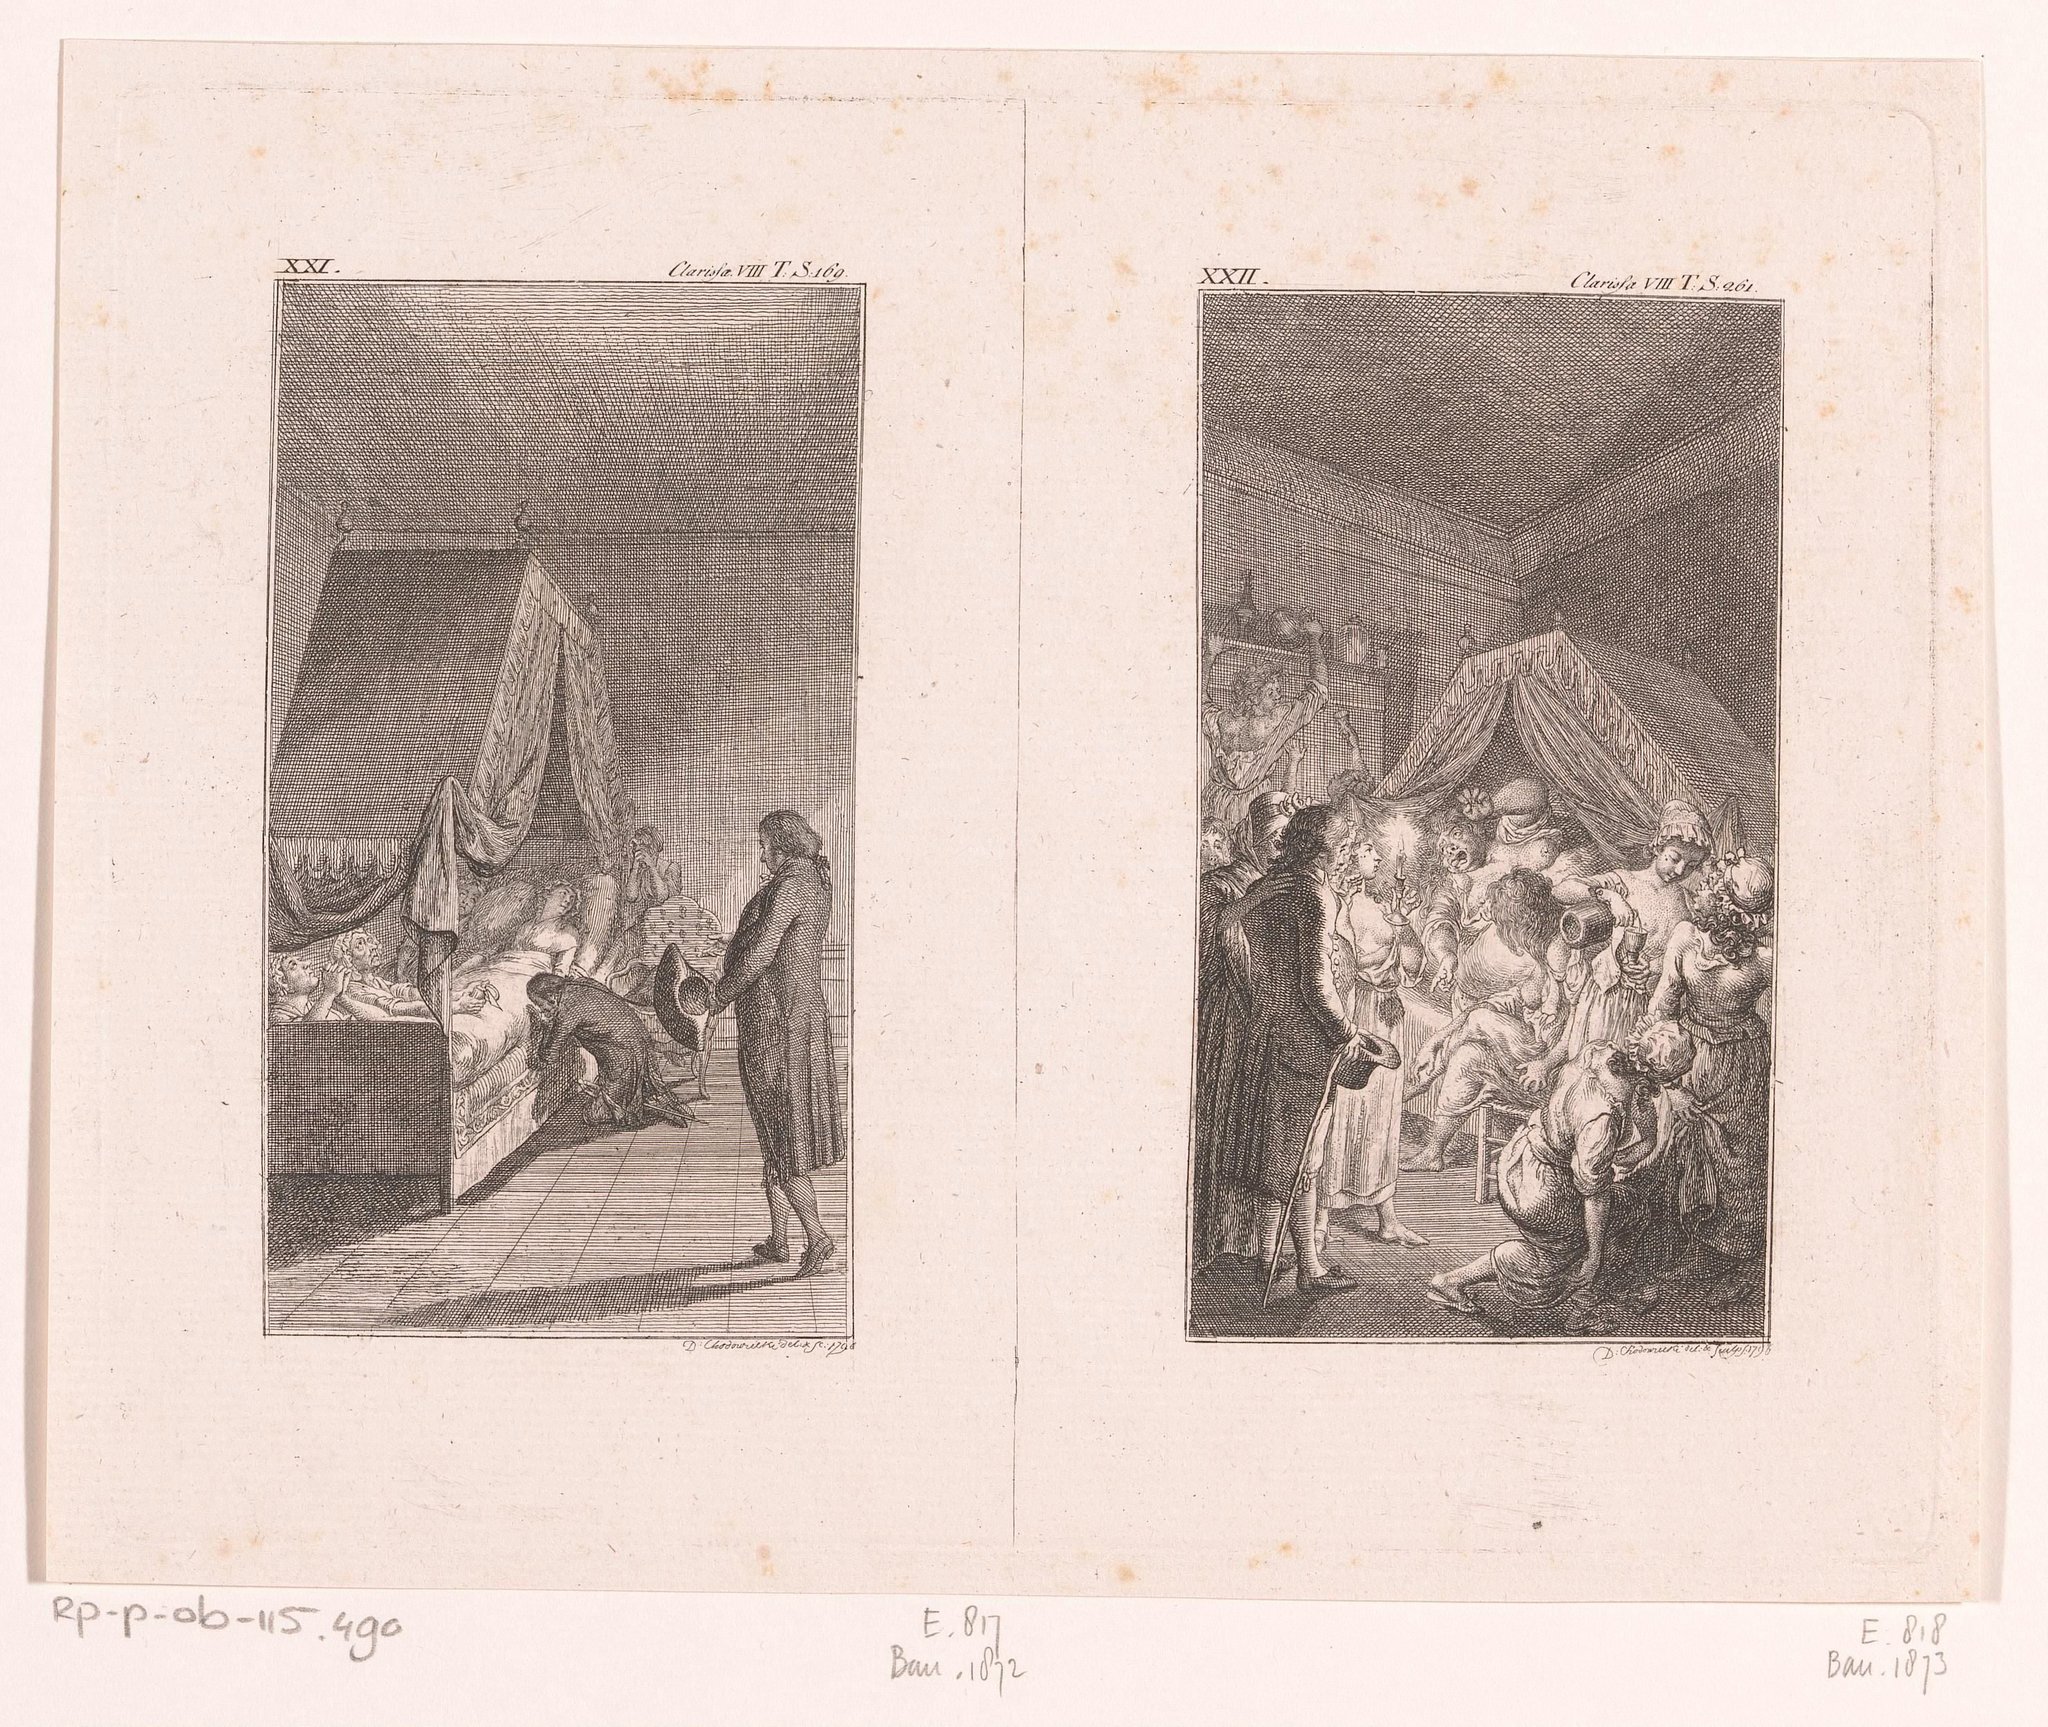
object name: print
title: Twee voorstellingen uit Clarissa van Samuel Richardson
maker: daniel nikolaus chodowiecki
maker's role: draughtsman, print maker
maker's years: 1726-1801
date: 1796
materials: paper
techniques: etching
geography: berlin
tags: literature, drunkard, deathbed, weeping, coitus, cohabiting, sexual intercourse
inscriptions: collector's mark: Lugt 2228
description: Prenten gebruikt voor: Richardson, Samuel. Clarissens Schicksale dargestellt in vier und zwanzig Kupferblättern von Daniel Chodowiecki. mit Erläuterungen des Deutschen Uebersetzers Dr. L. Th. Kosegarten. Leipzig: Heinrich Gräff, 1796.